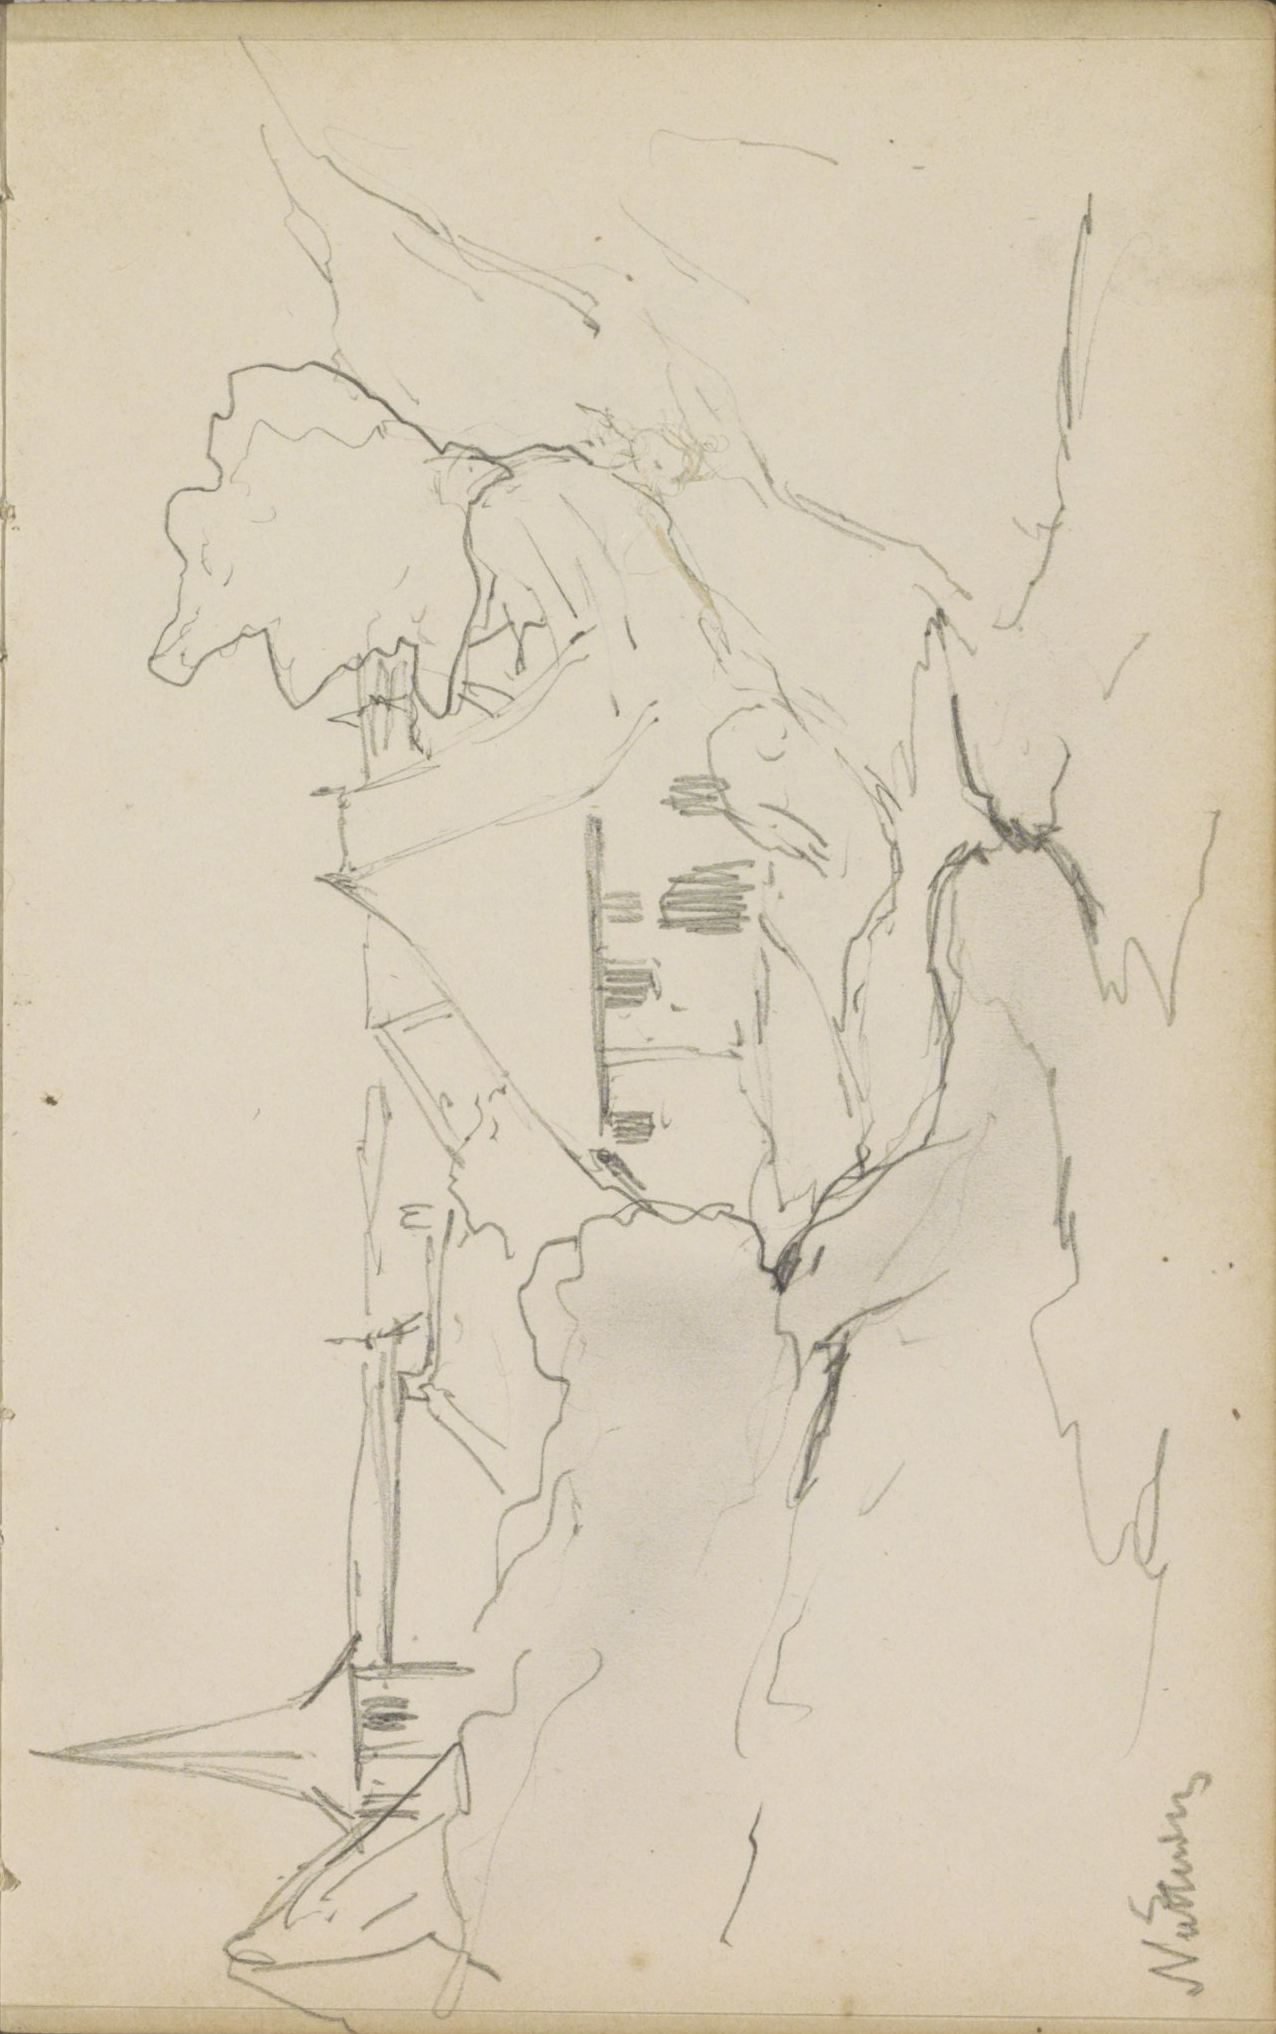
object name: sketchbook leaf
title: Dorp bij Kleef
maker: johannes tavenraat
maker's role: draughtsman, painter, print maker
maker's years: 1809-1881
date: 1839-1872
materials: paper, pencil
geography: cleves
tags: city-view, and landscape with man-made constructions, road, path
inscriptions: annotation: ‘Nu[...]tte[...]’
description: Blad 53 recto uit een schetsboek met 73 bladen.